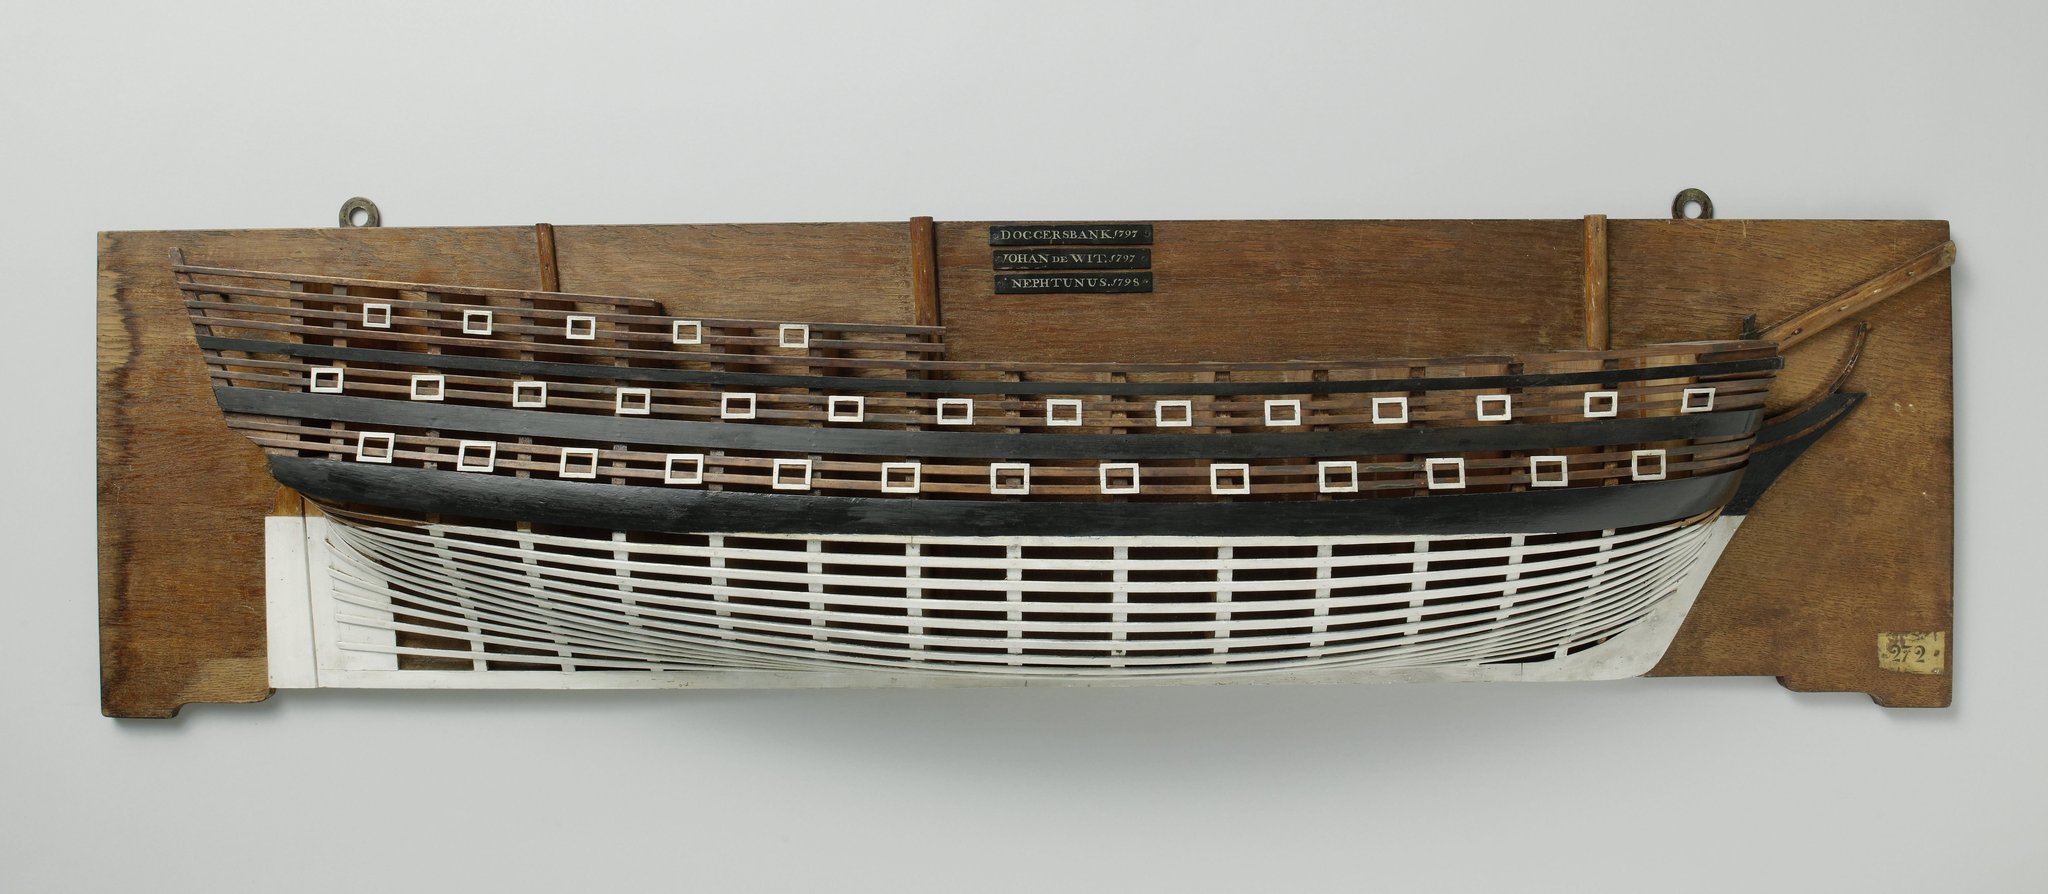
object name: ship model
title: Half Model of a 68-Gun Ship of the Line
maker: Anonymous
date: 1797-1798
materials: wood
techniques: polychromy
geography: netherlands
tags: neptunus (schip), zeeland (schip), joan de wit (schip), doggersbank (schip)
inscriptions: label, bottom right: ‘272’ former inventory label, inscription, top centre, on three square black metal labels: ‘DOGGERSBANK. 1797 // JOHAN de WIT. 1797 // NEPHTUNUS. 1798’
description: Half-model of a 68-gun ship of the line, by Pieter Glavimans Jz, c. 1797-1798. Scale c. 1/50. Under the Batavian Republic a major naval shipbuilding programme was undertaken. The dramatic losses suffered by the fleet in encounters with the British made this essential: the Dutch navy had been outclassed by the larger, modernised British ships. Glavimans Jz. (1768-1850), nephew of the navy's constructor general, Pieter Glavimans, was a shipwright at the Rotterdam shipyard. He built three ships of this type.